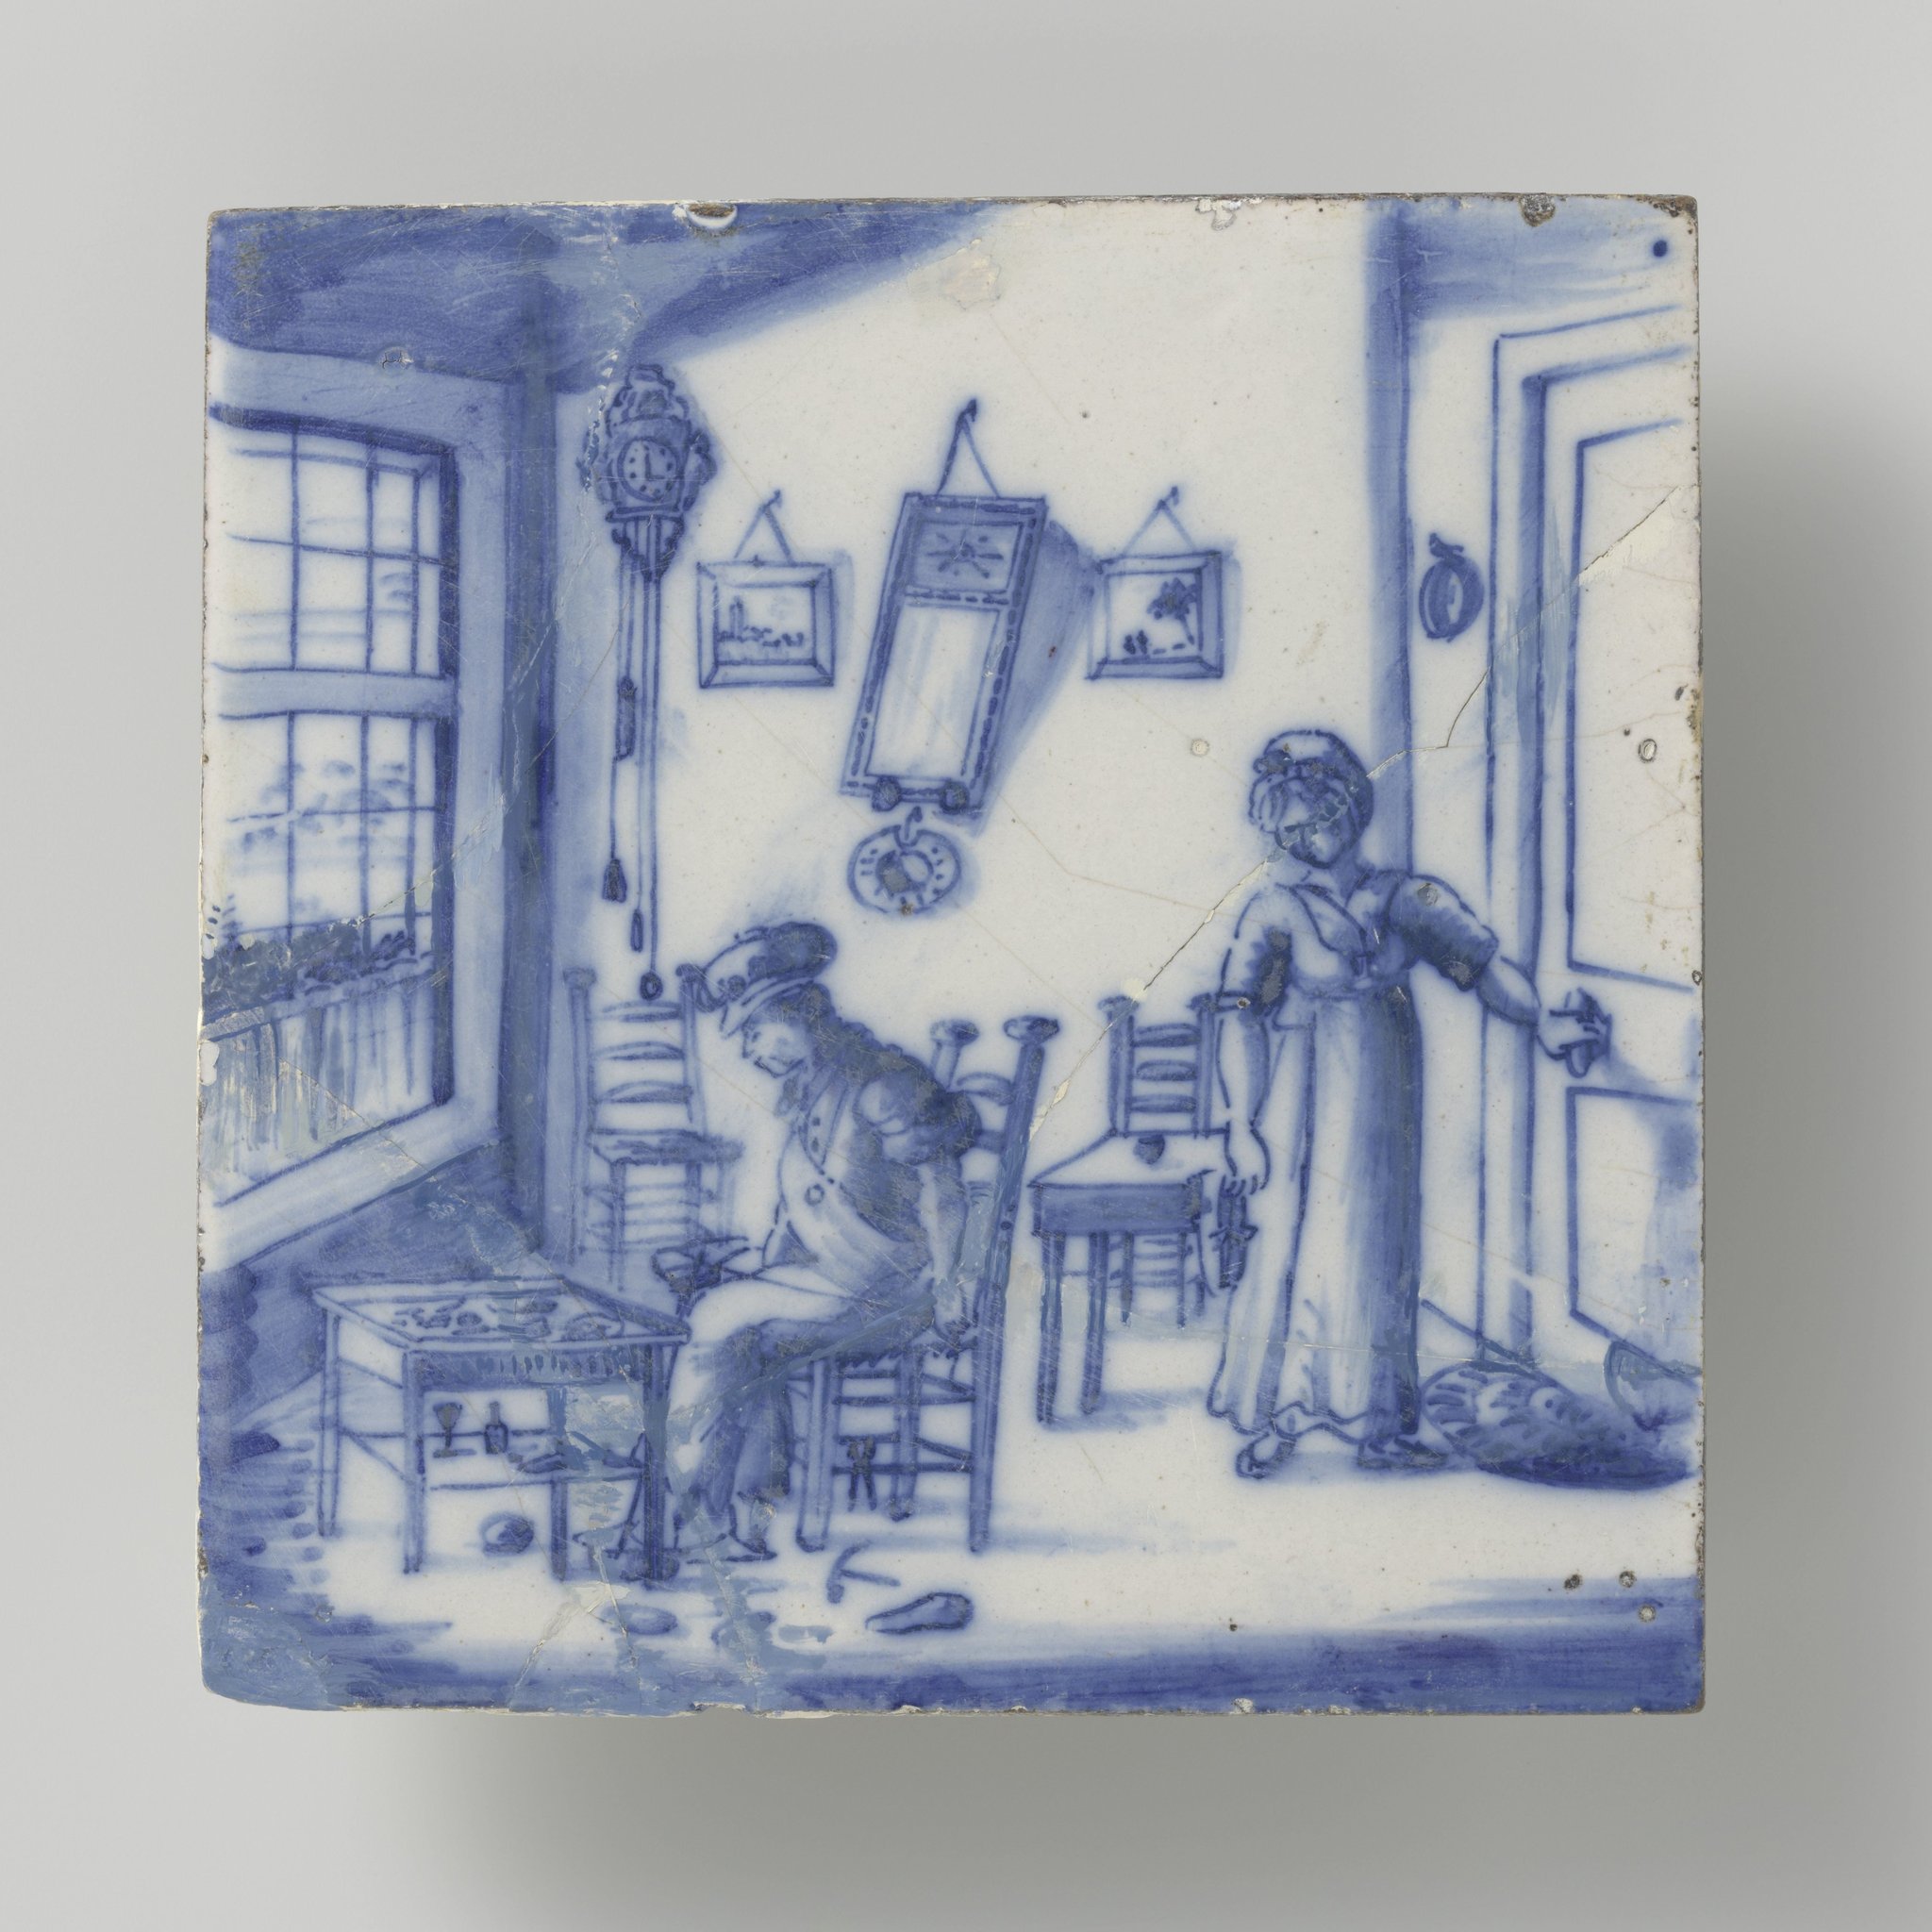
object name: tile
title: Tegel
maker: Anonymous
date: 1800-1830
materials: earthenware, glaze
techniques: maiolica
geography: netherlands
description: Tegel met een blauw geschilderde interieur scène van een schoenmakerij.